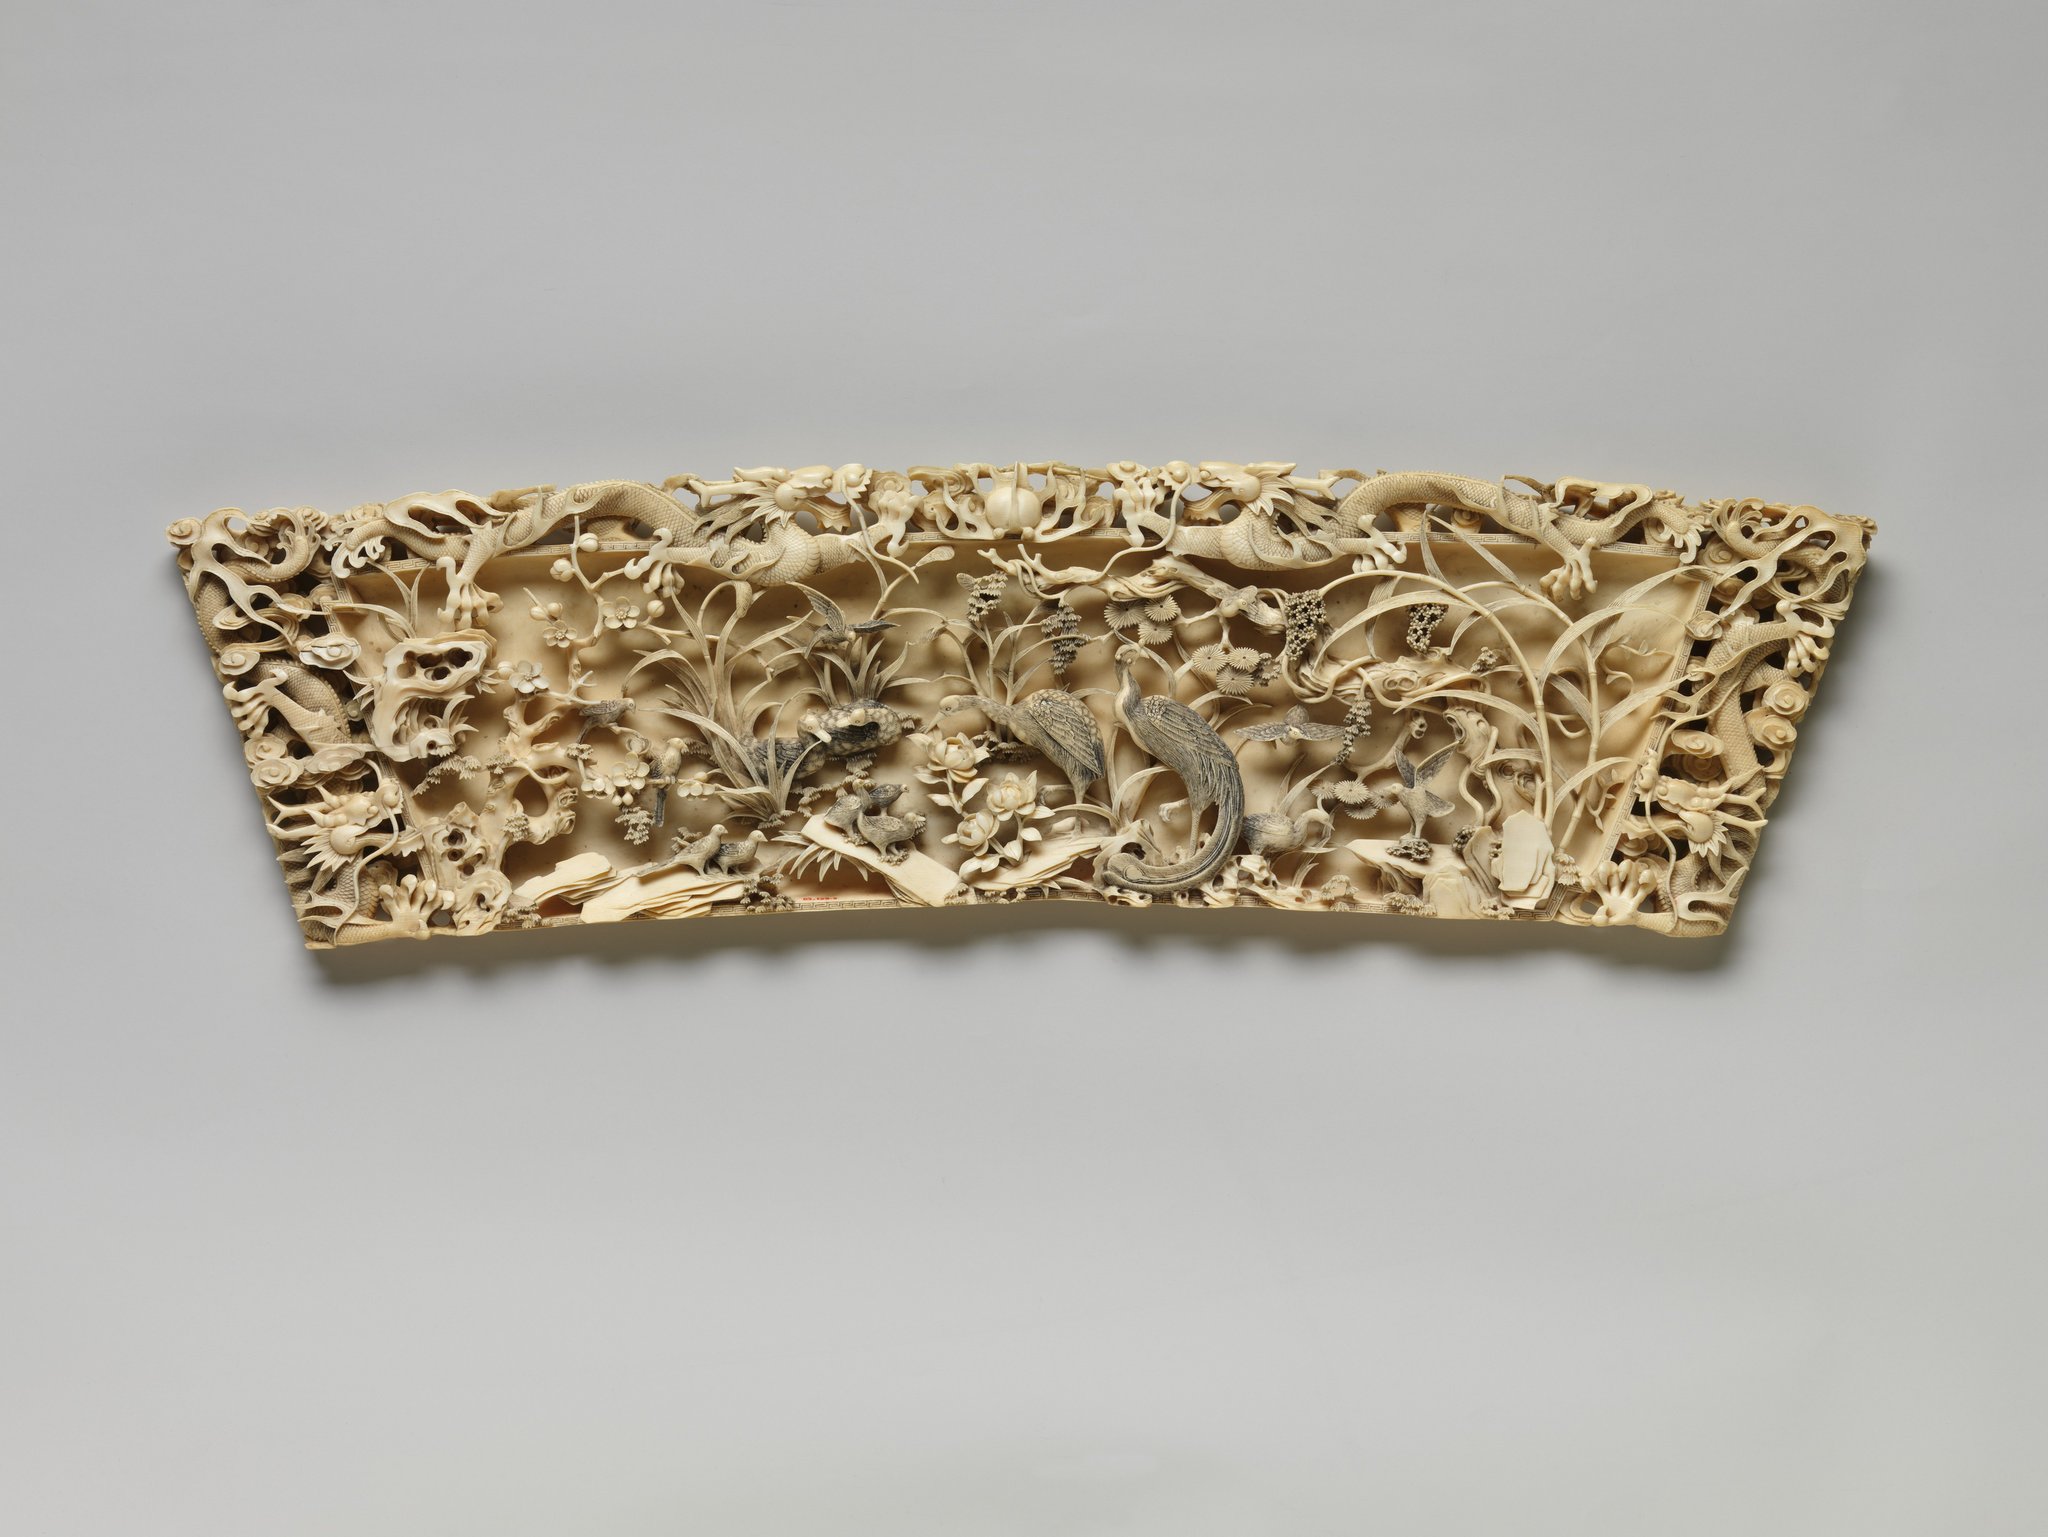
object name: plaque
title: Plaque with dragon, pheasant, quail, and other birds amidst bamboo and plum blossom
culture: chinese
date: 1867-1900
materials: ivory, pigment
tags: birds,dragons,plants